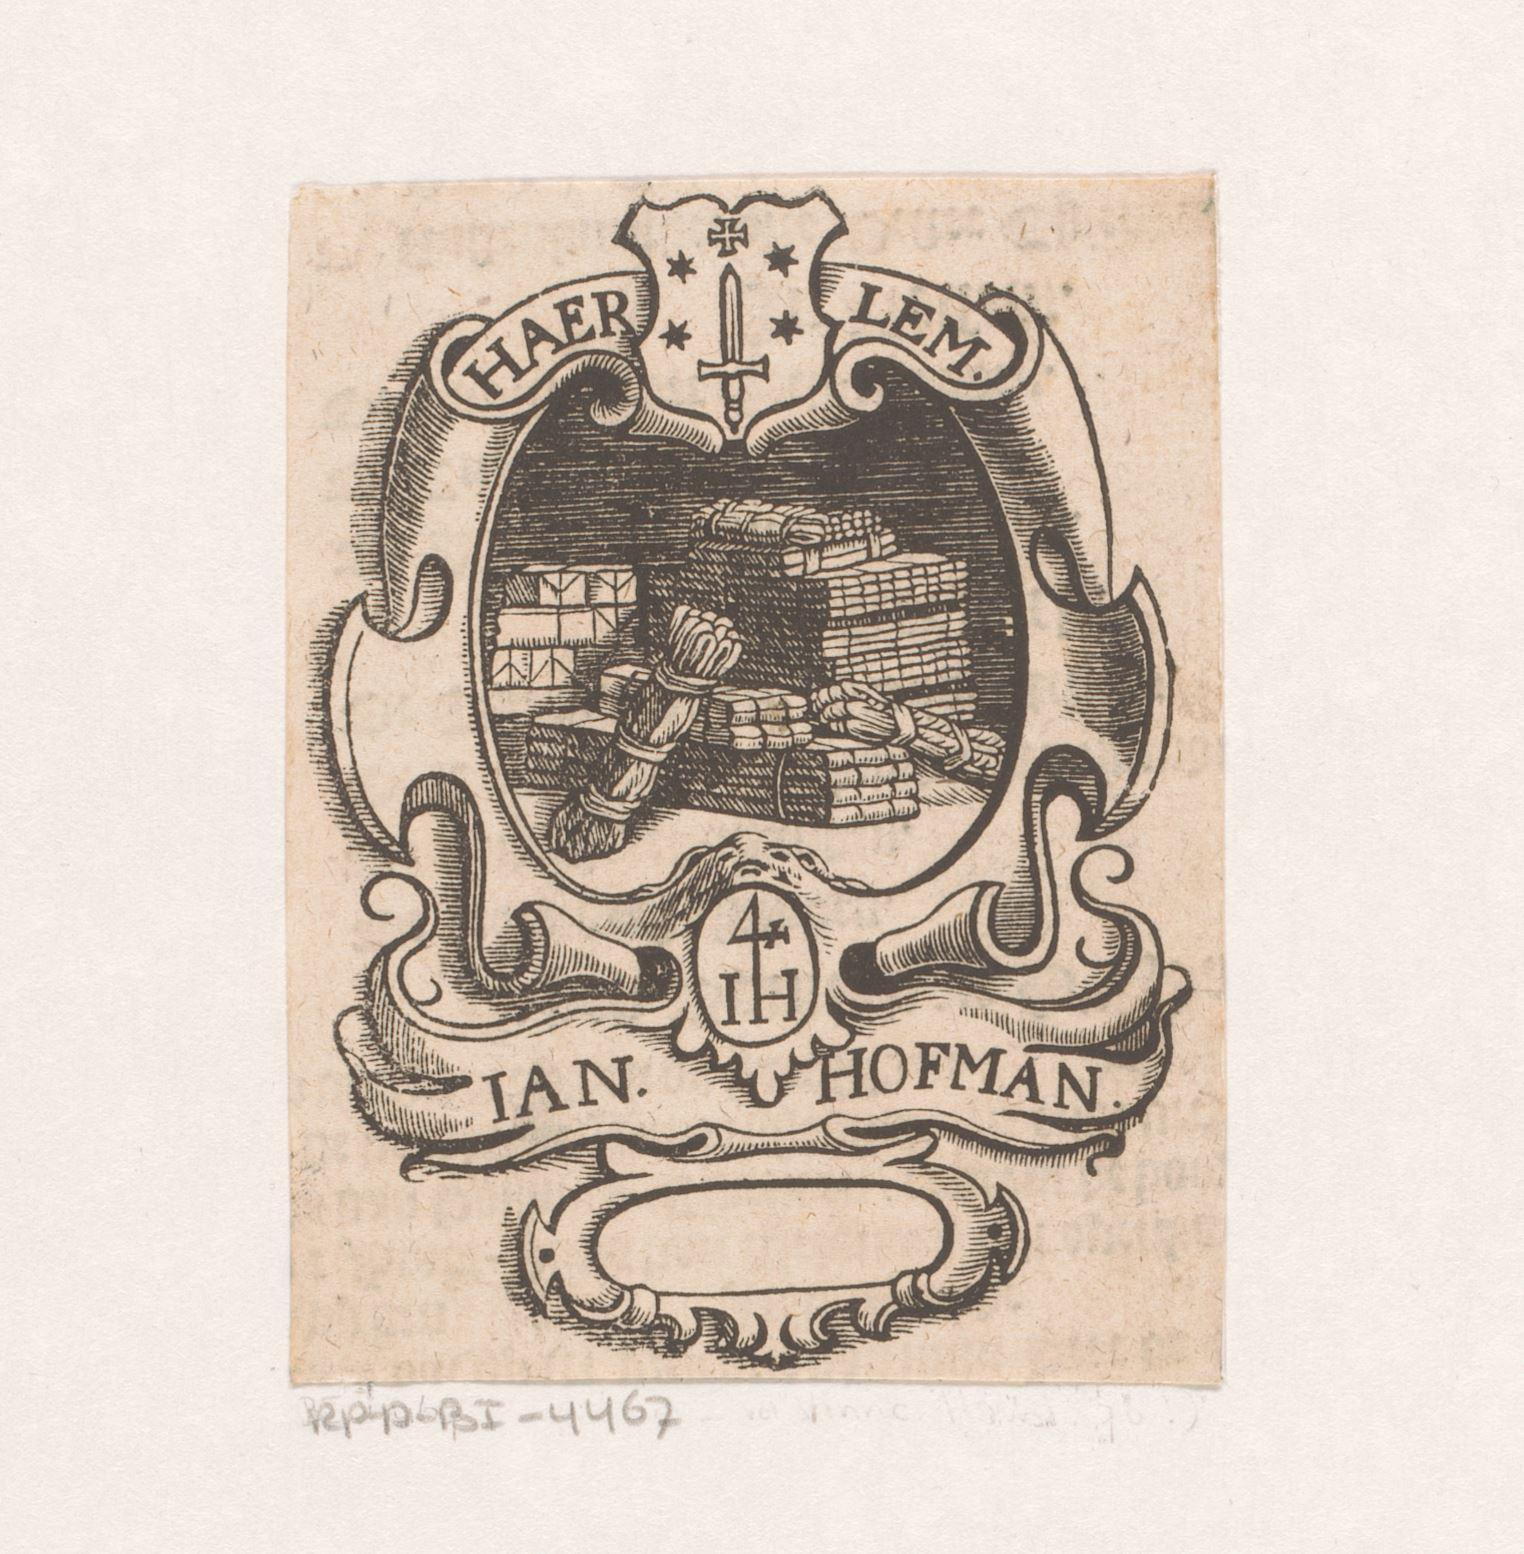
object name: handelsetiket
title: Handelsetiket van Jan Hofman te Haarlem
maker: Anonymous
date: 1681-1740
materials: paper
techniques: letterpress printing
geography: netherlands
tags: coat of arms (as symbol of the state, etc.) (+ city; municipal), vignette, haarlem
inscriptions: collector's mark: Lugt 240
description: Stapels goederen in een geornamenteerde omlijsting. Midden boven het wapen van de stad Haarlem. Midden onder het monogram van Nicolas Hofman.